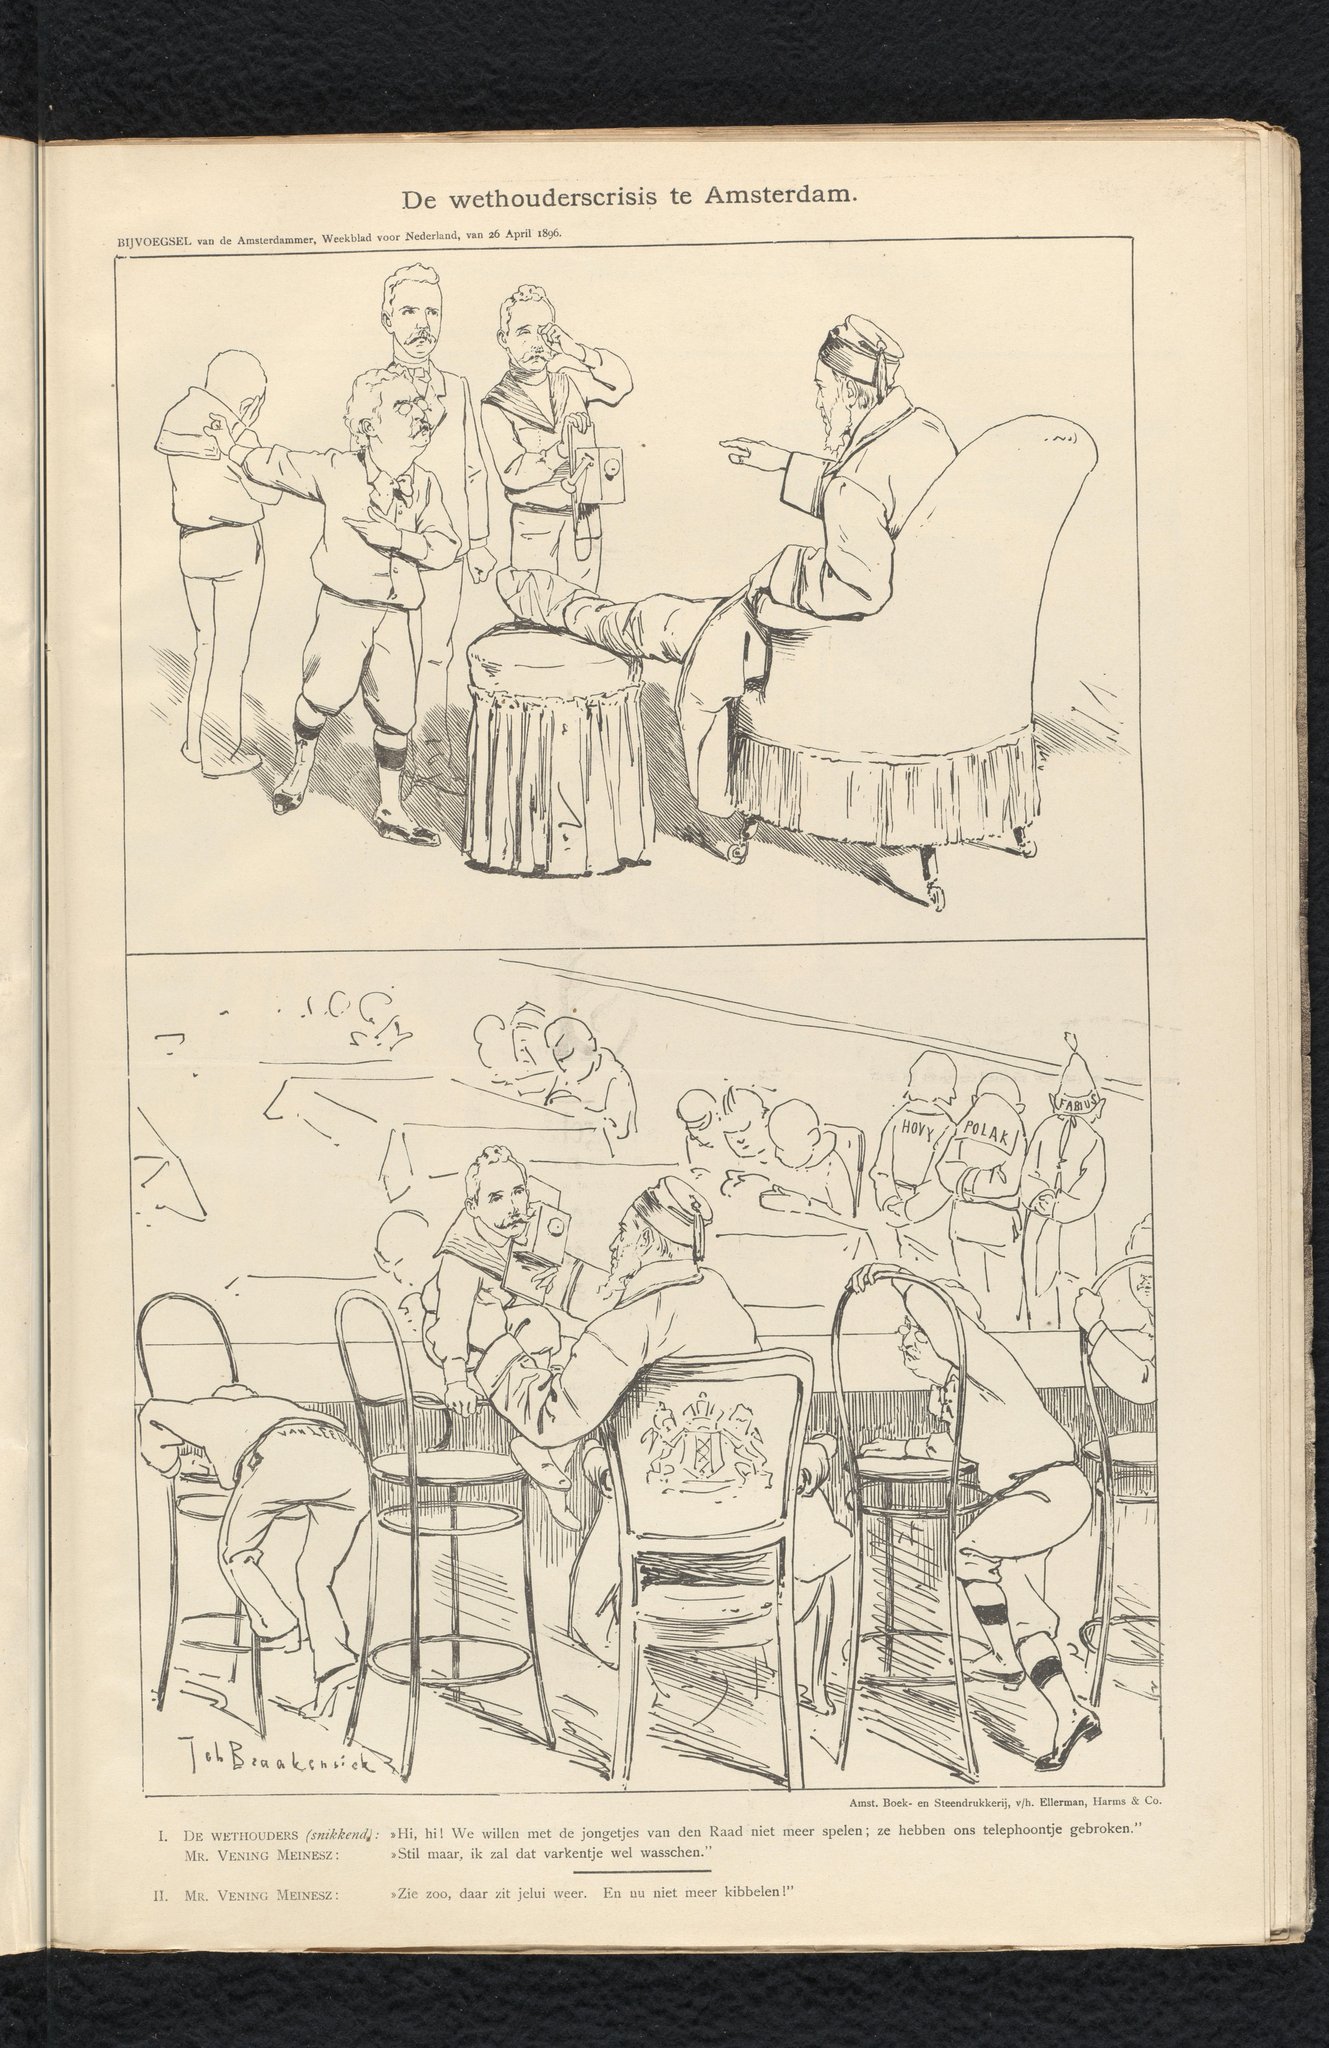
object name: cartoon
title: De wethouderscrisis te Amsterdam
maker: johan braakensiek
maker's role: draughtsman, print maker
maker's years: 1858-1940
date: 1896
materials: paper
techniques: lithograph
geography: amsterdam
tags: harlingen, municipal government, amsterdam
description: Twee voorstellingen van problemen in de Amsterdamse raad met burgemeester Sjoerd Vening Meinesz en wethouders.